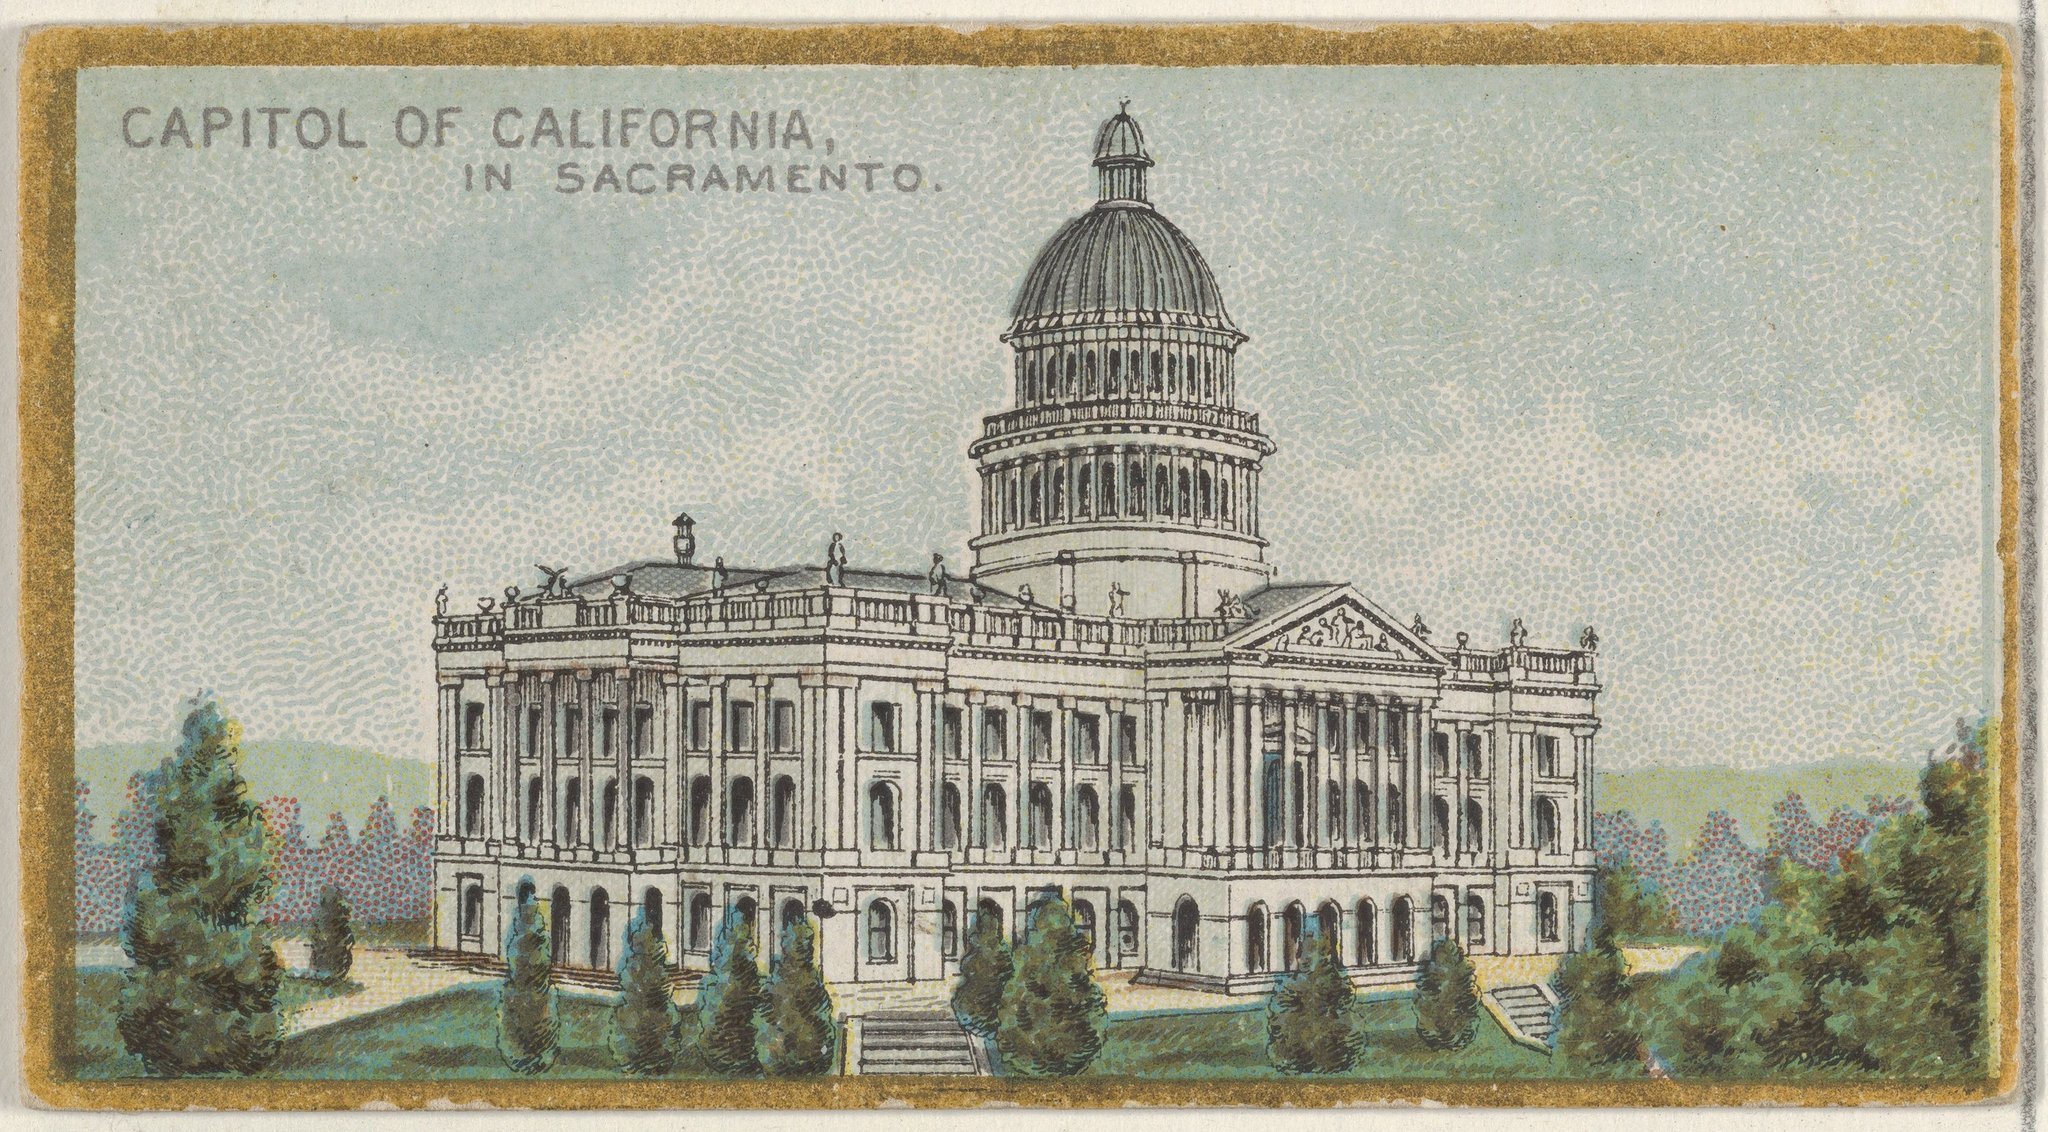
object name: print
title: Capitol of California in Sacramento, from the General Government and State Capitol Buildings series (N14) for Allen & Ginter Cigarettes Brands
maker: allen & ginter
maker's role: publisher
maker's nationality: american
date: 1889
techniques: color lithograph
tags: buildings